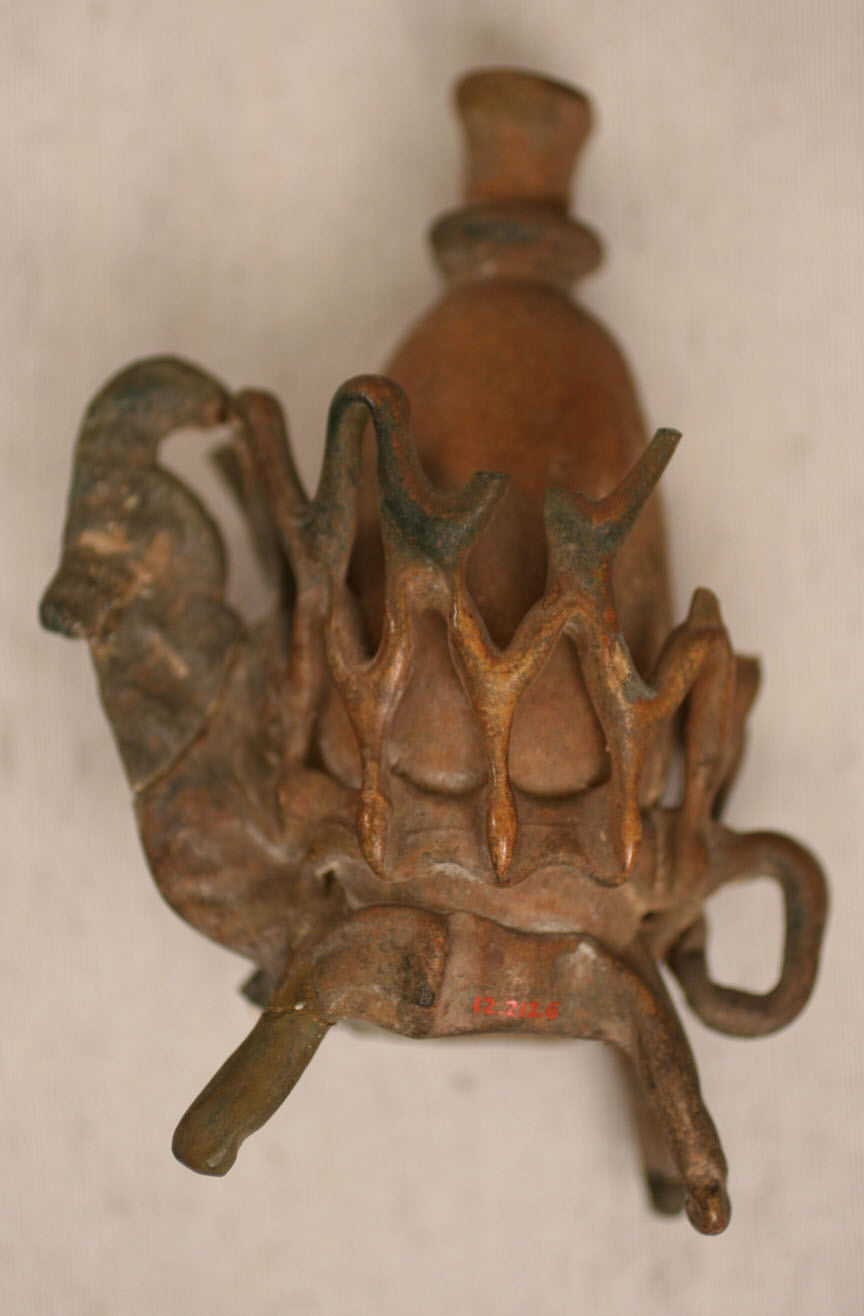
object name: flask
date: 601-800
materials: glass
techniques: glassblowing, tooling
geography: egypt or syria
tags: animals